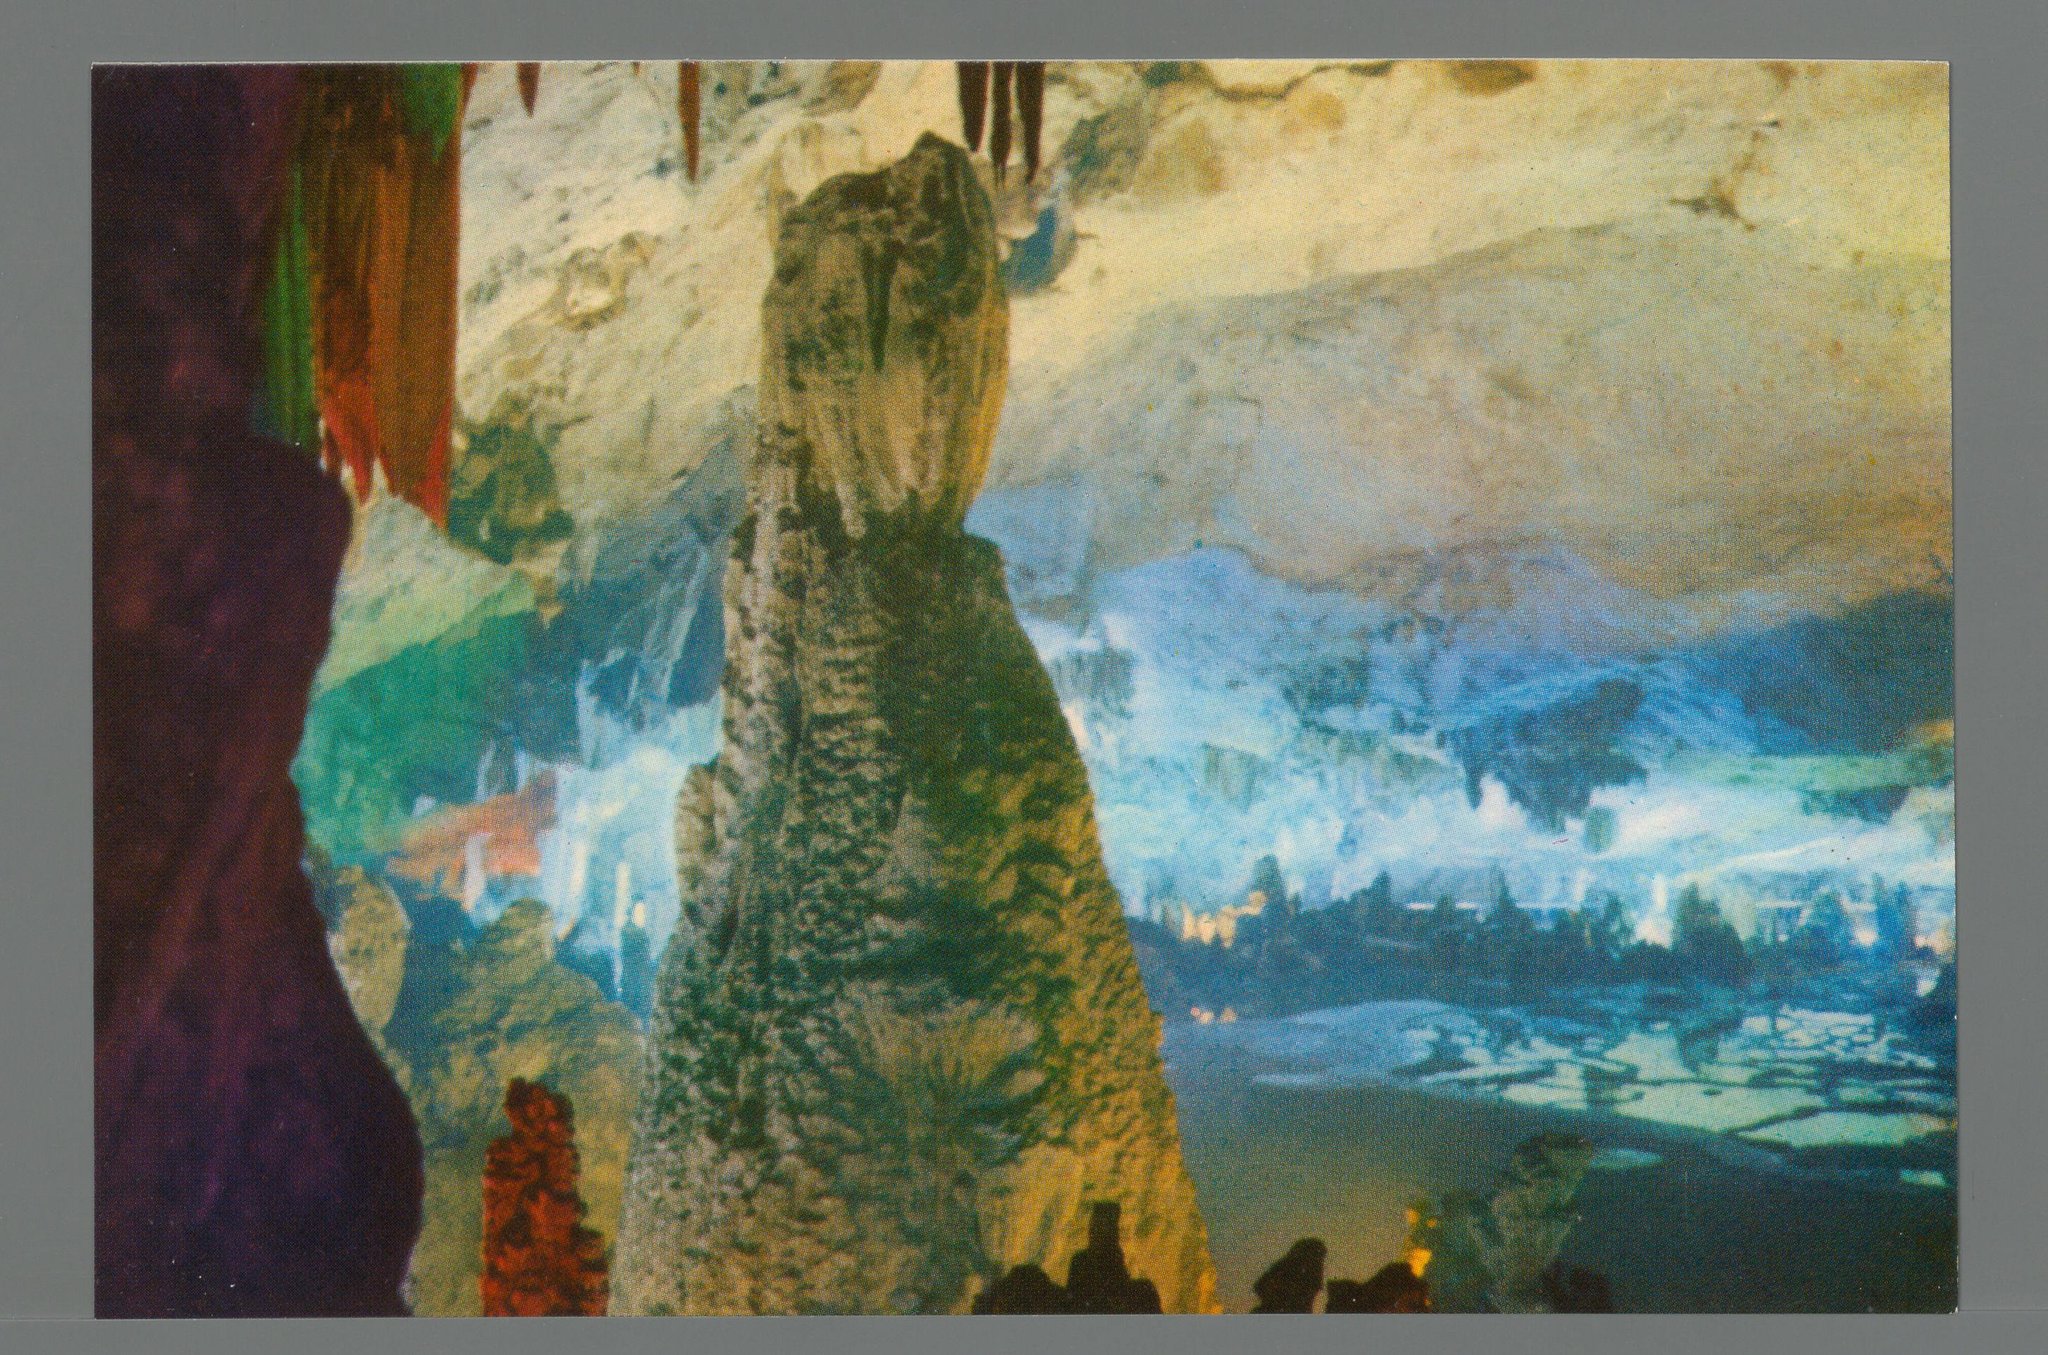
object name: ansichtkaart, prentbriefkaart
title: Dripstones in Reed Flute Cavern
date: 1974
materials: cardboard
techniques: offset printed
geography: guilin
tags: stalactitic cave